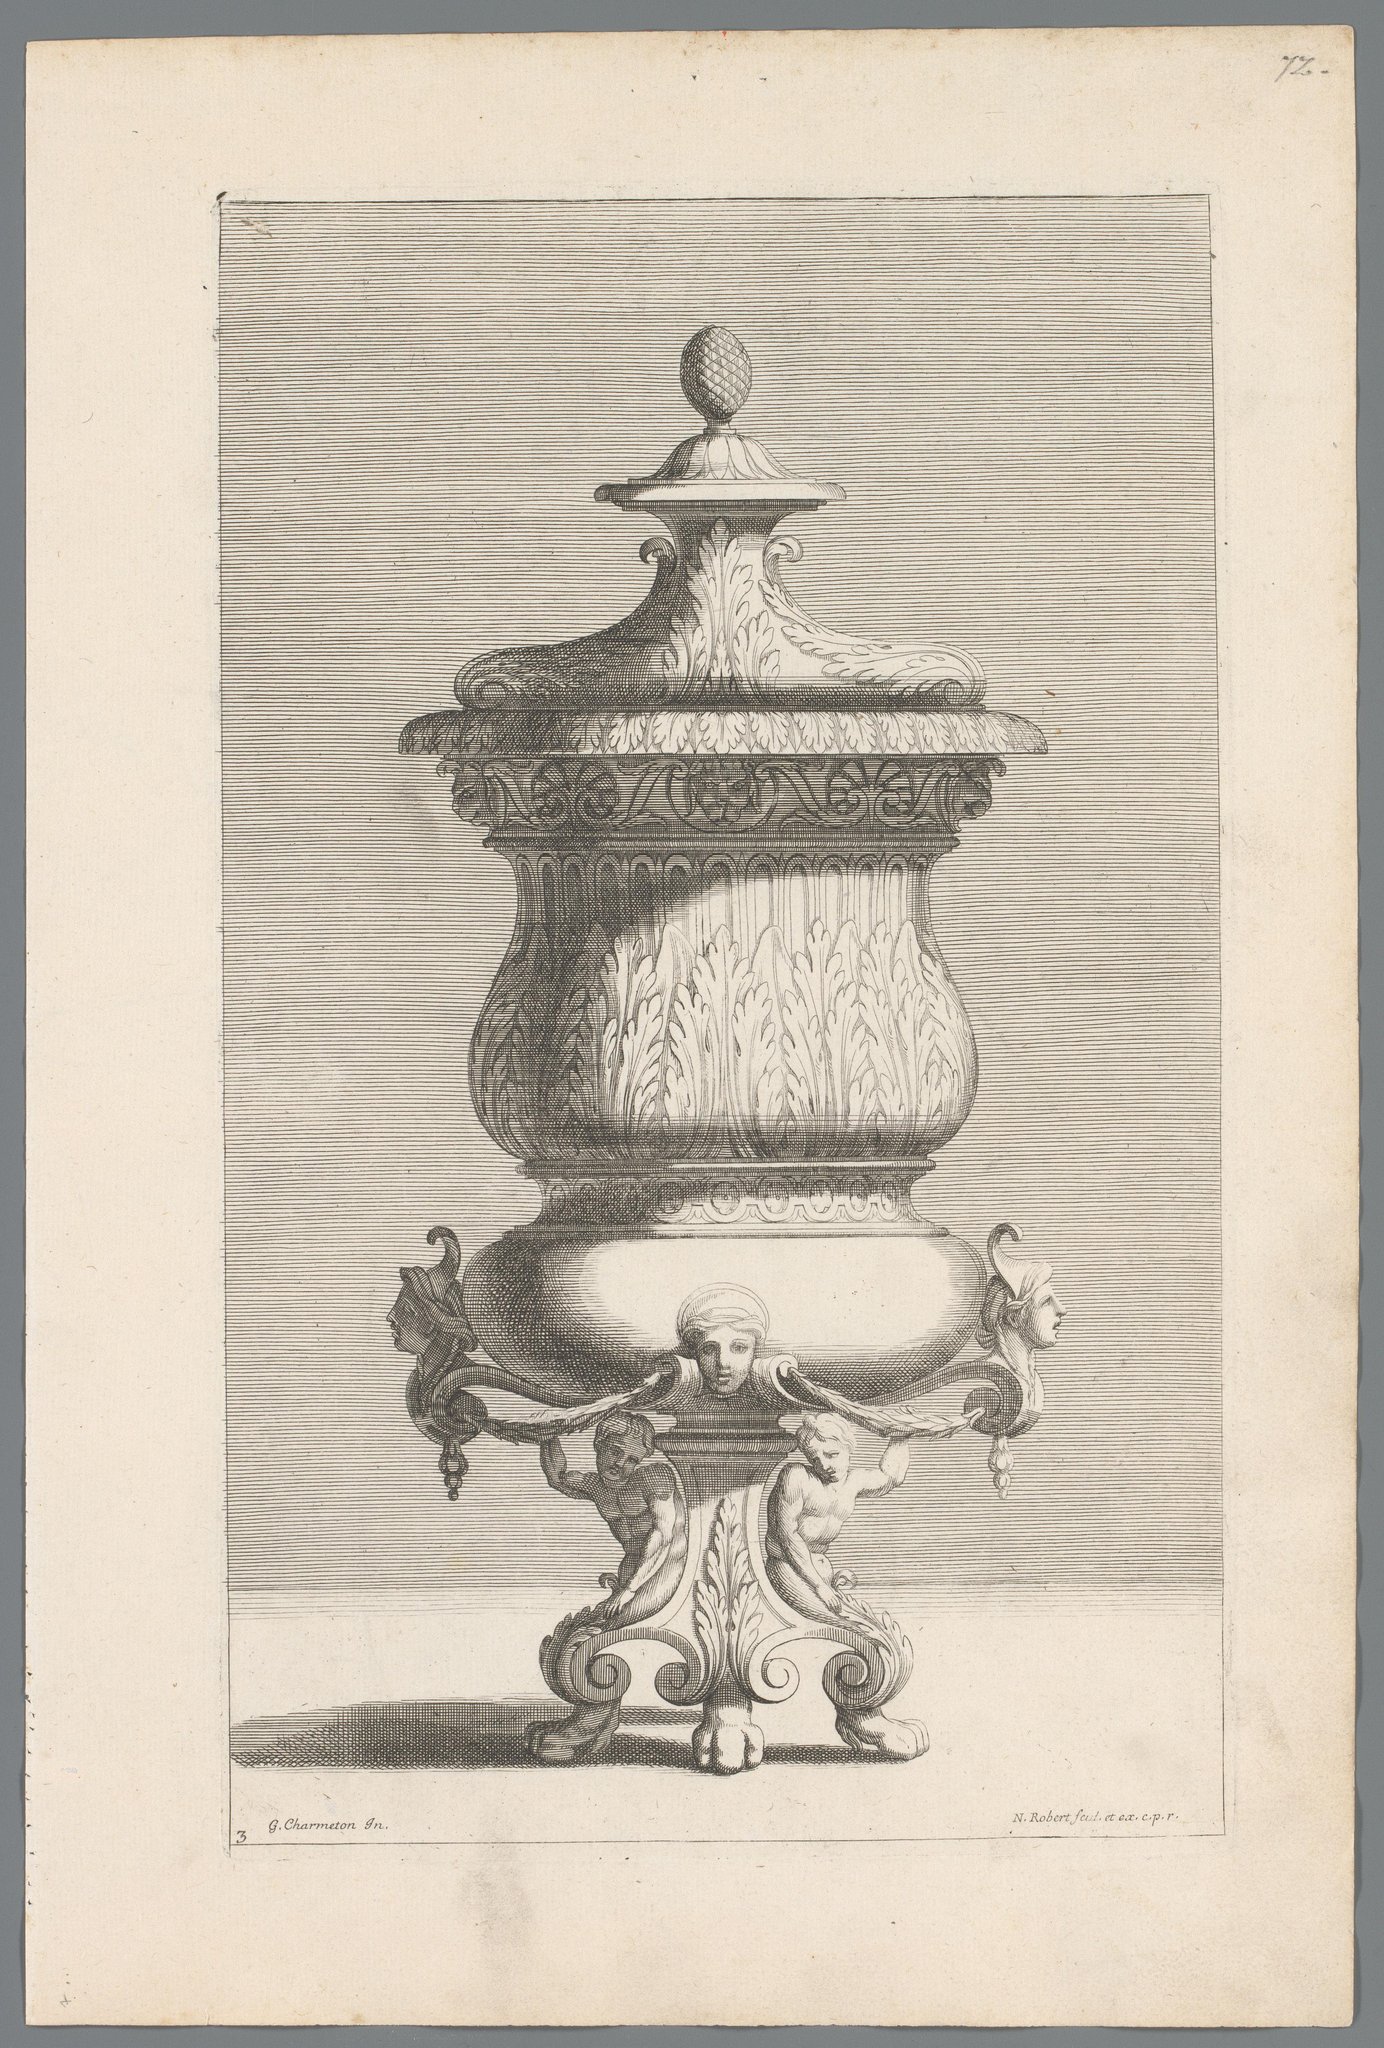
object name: ornament print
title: Vaas met deksel op een voet met leeuwenpoten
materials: paper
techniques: engraving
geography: paris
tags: vase ~ ornament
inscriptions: collector's mark: Lugt 2760, collector's mark: Lugt 2228